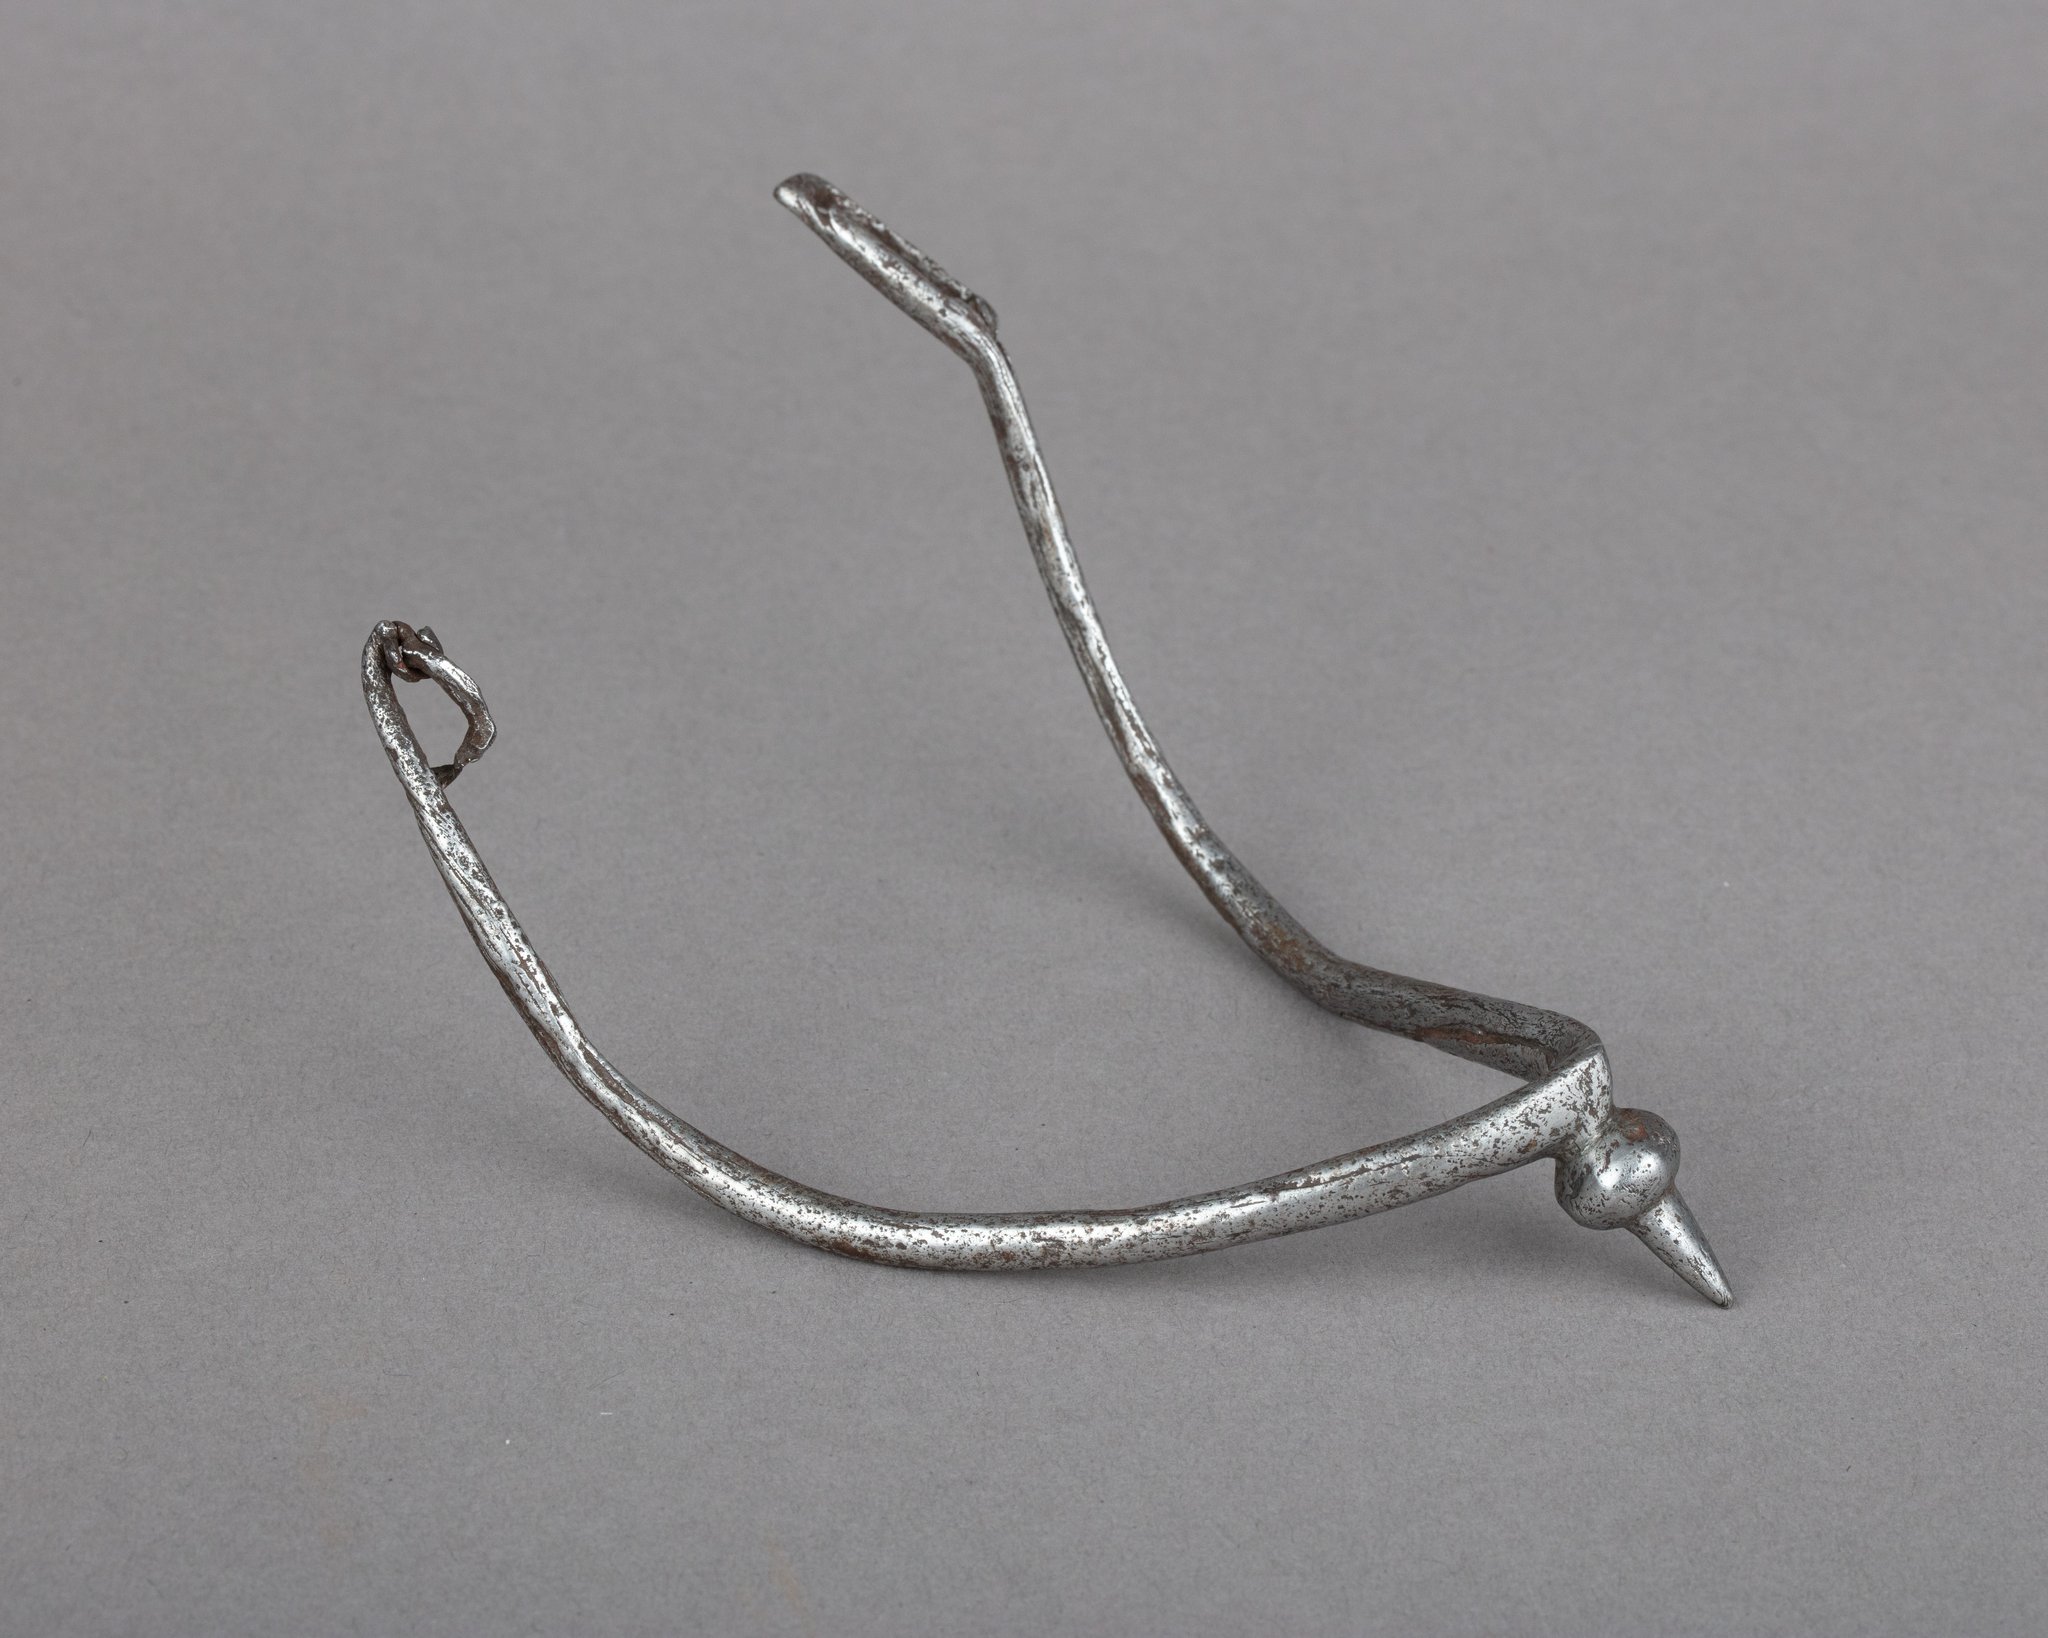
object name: spur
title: Prick Spur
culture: german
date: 1201-1300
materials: metal alloy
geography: germany